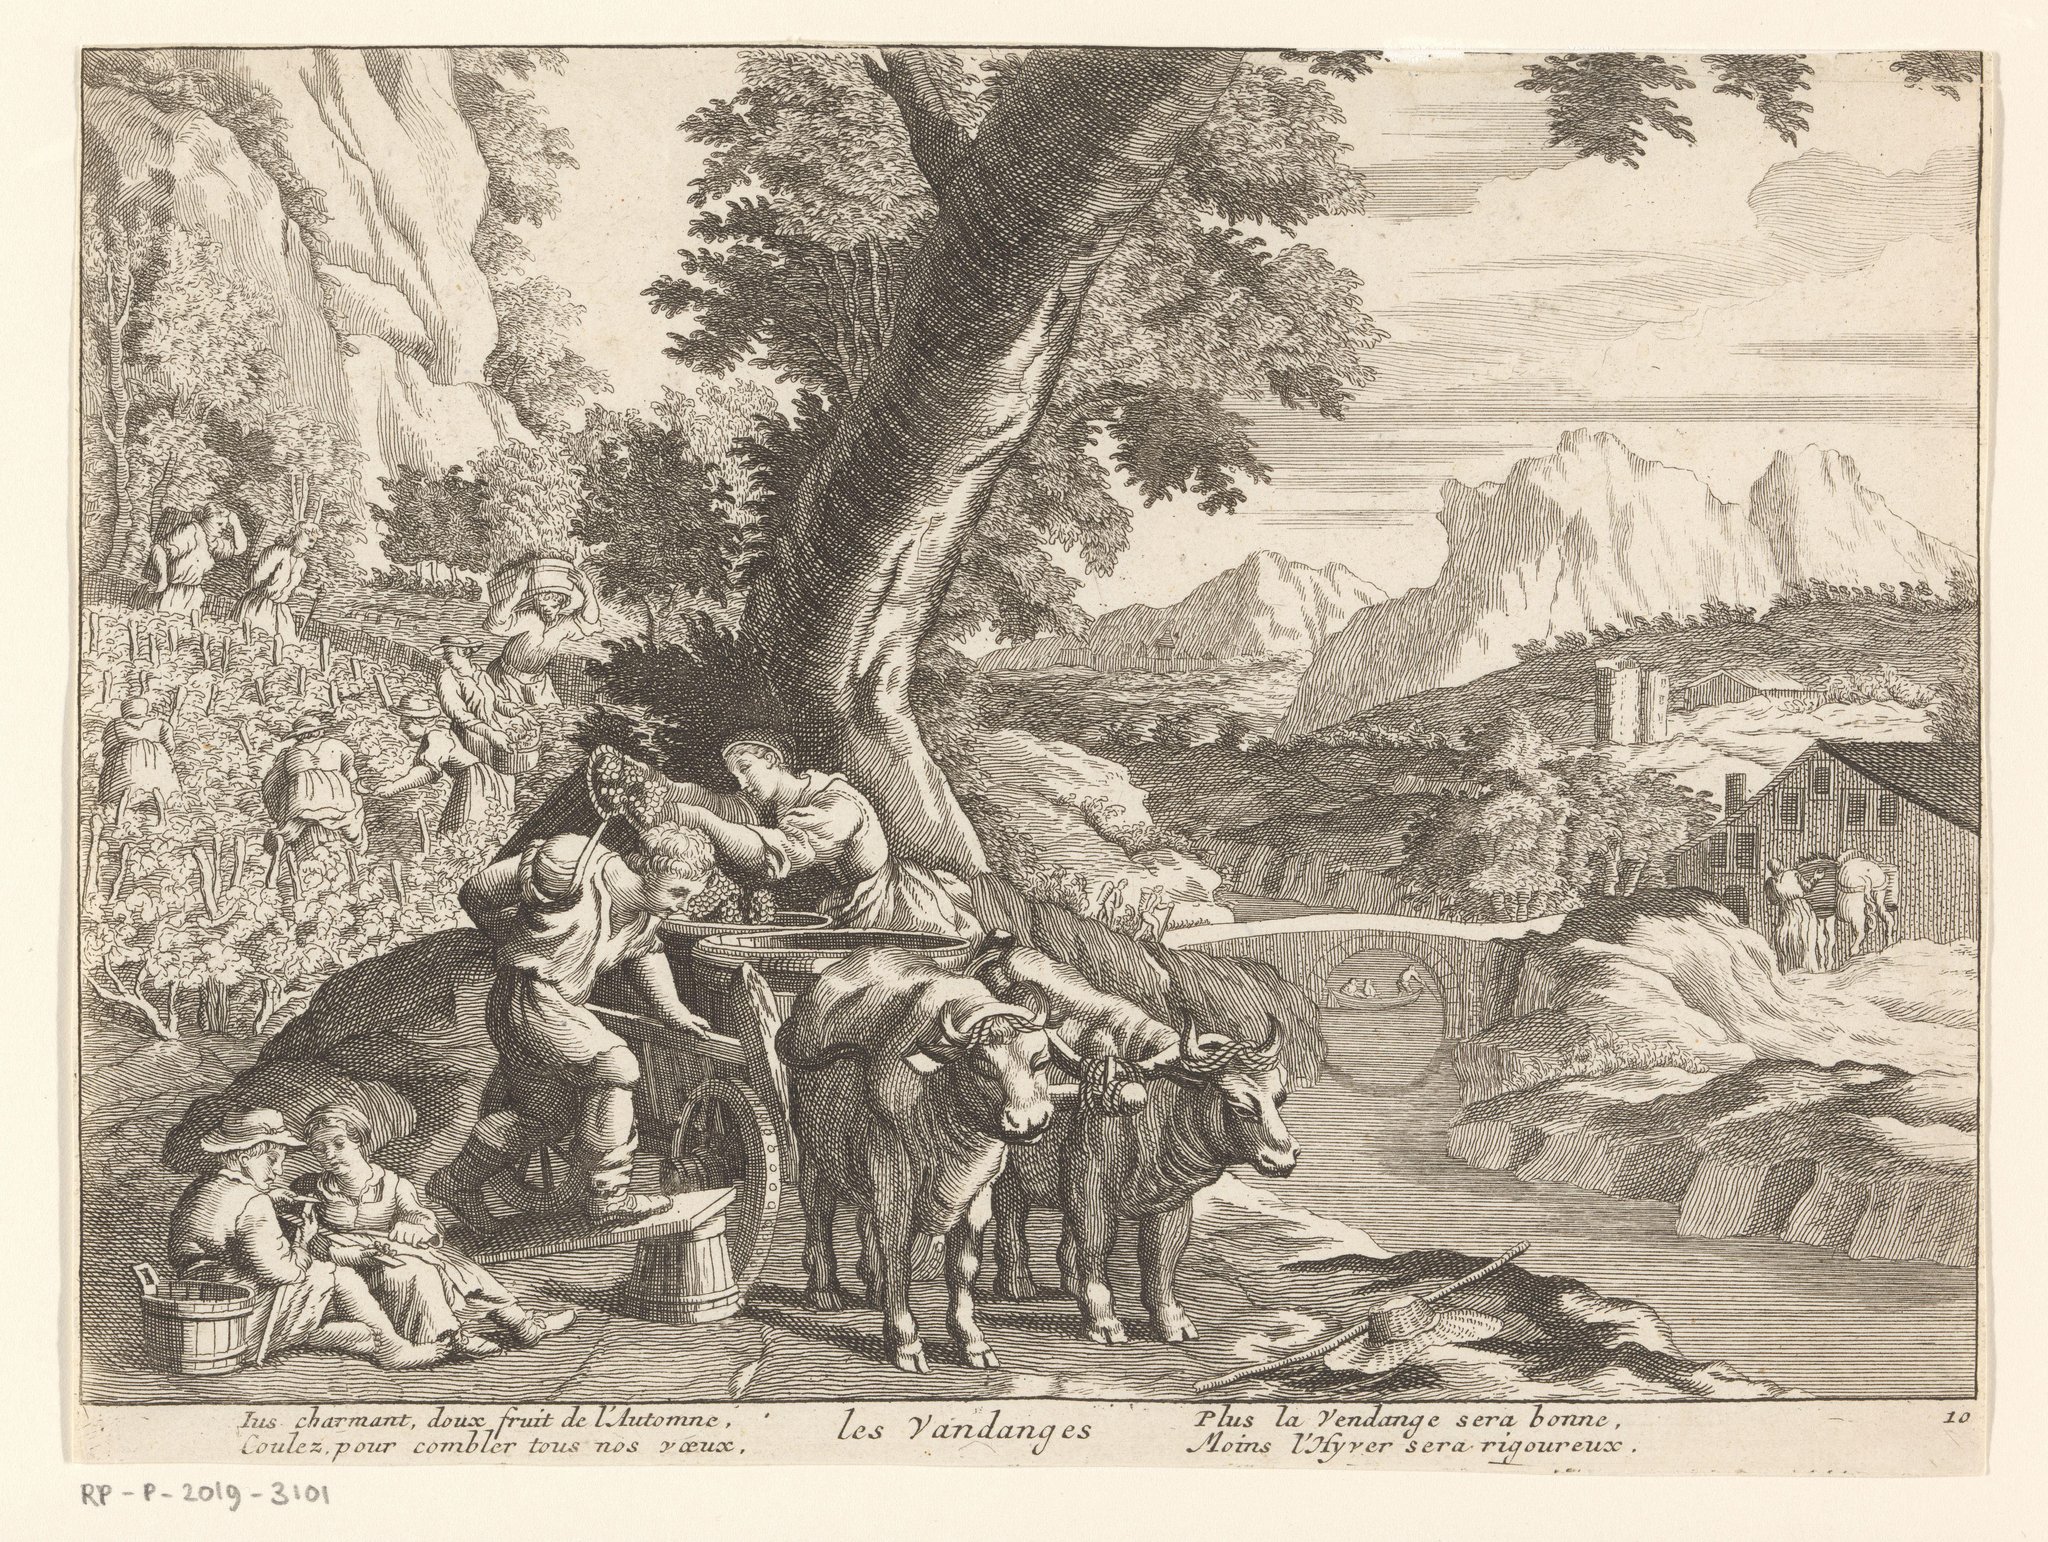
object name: print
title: Les Vandanges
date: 1661-1726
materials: paper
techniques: engraving, etching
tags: harvest, wine production, ox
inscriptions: collector's mark: Lugt 2228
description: Maakt deel uit van een zestiendelige serie met landelijke en pastorale scènes, uitgegeven door Gerard Valck.